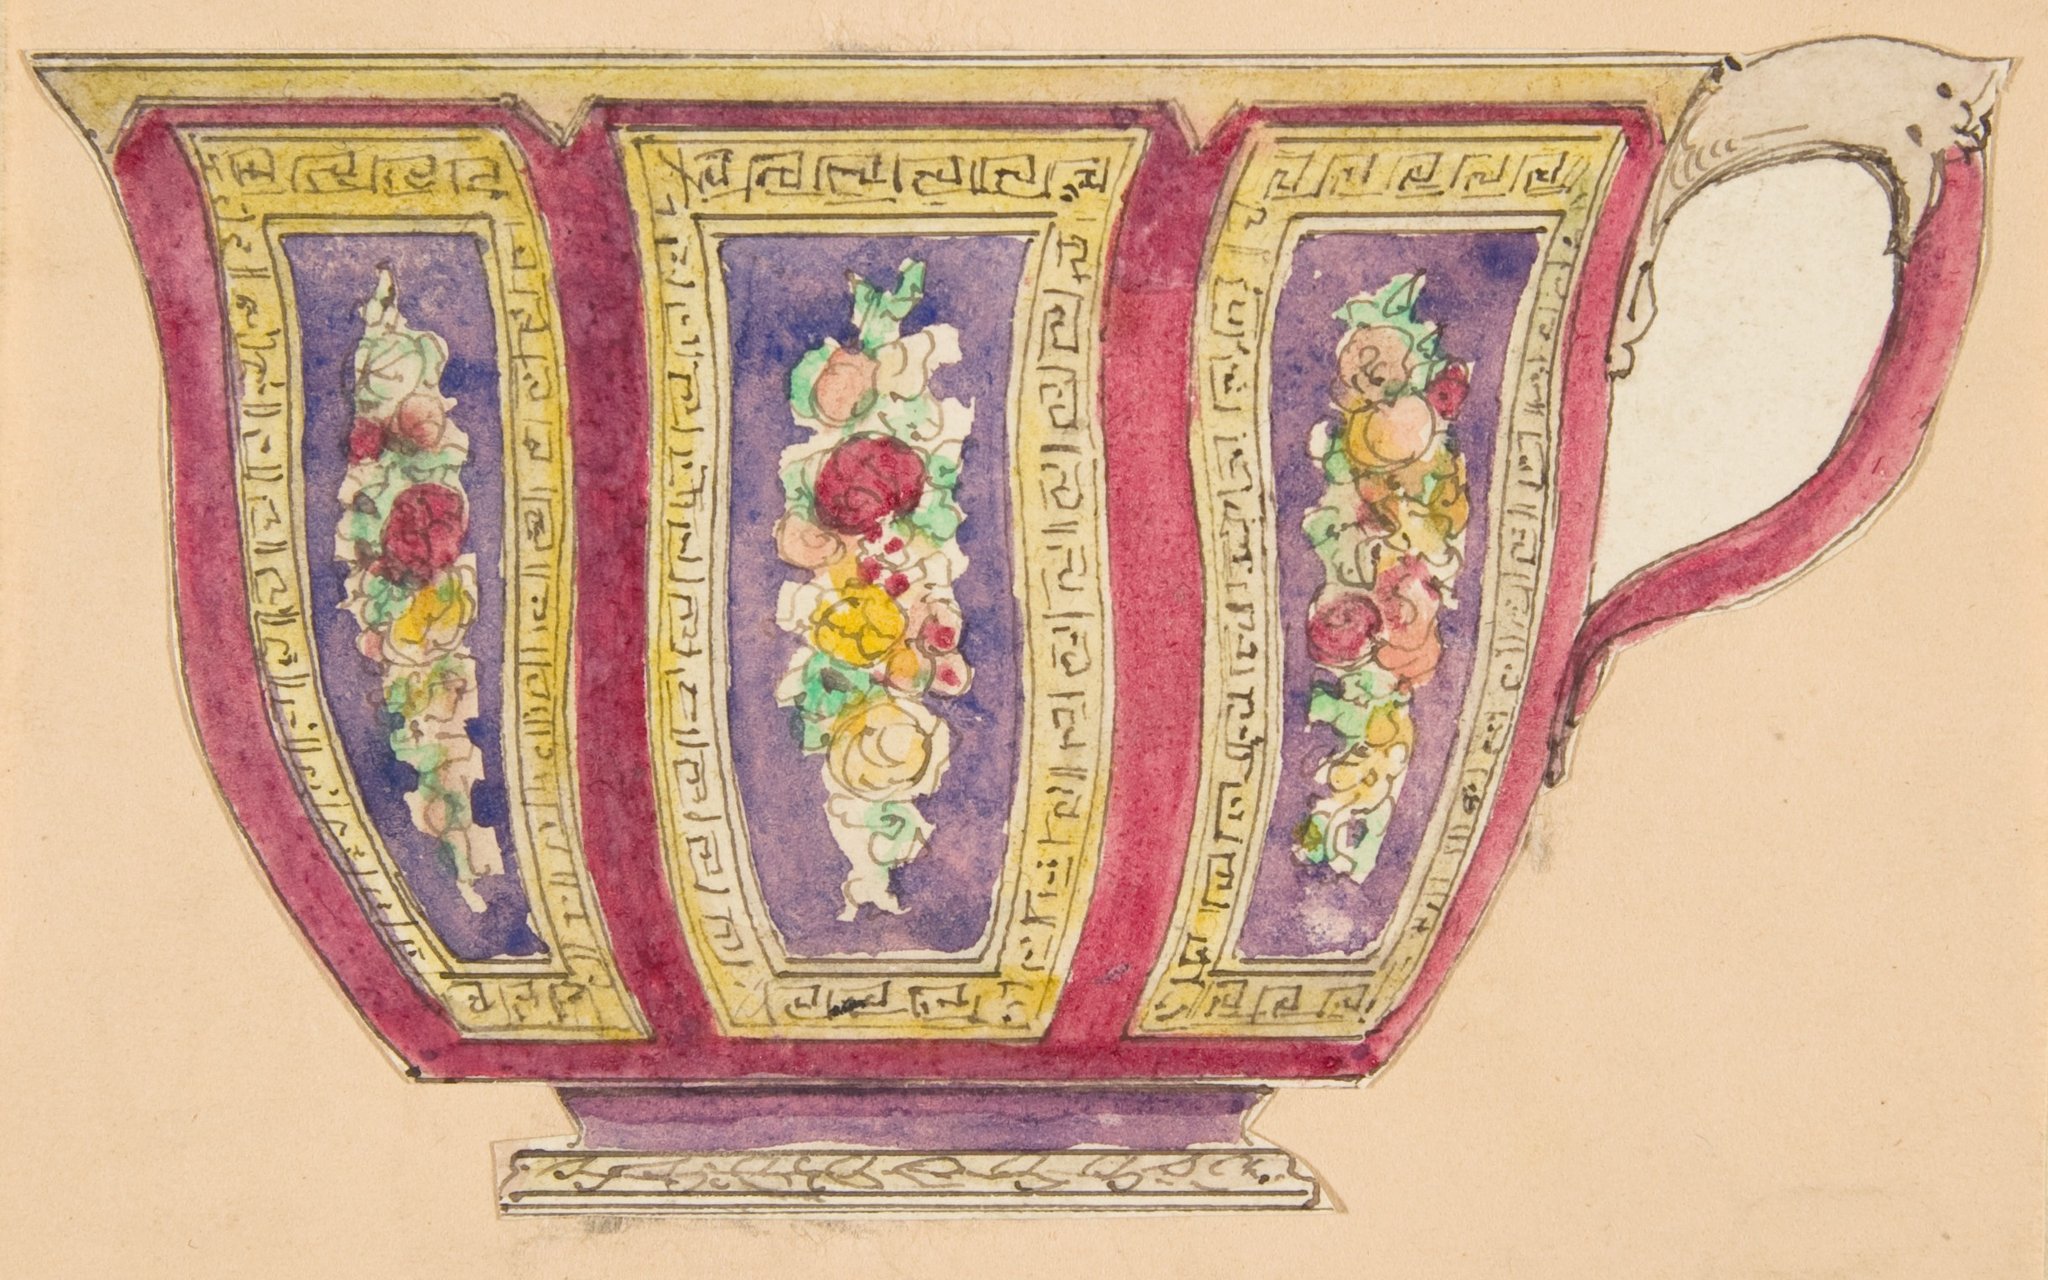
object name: drawing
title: Design for a cup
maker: anonymous, french, 19th century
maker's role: artist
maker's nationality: french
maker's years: 1800-1900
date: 1801-1900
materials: ink, watercolor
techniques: pen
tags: cups